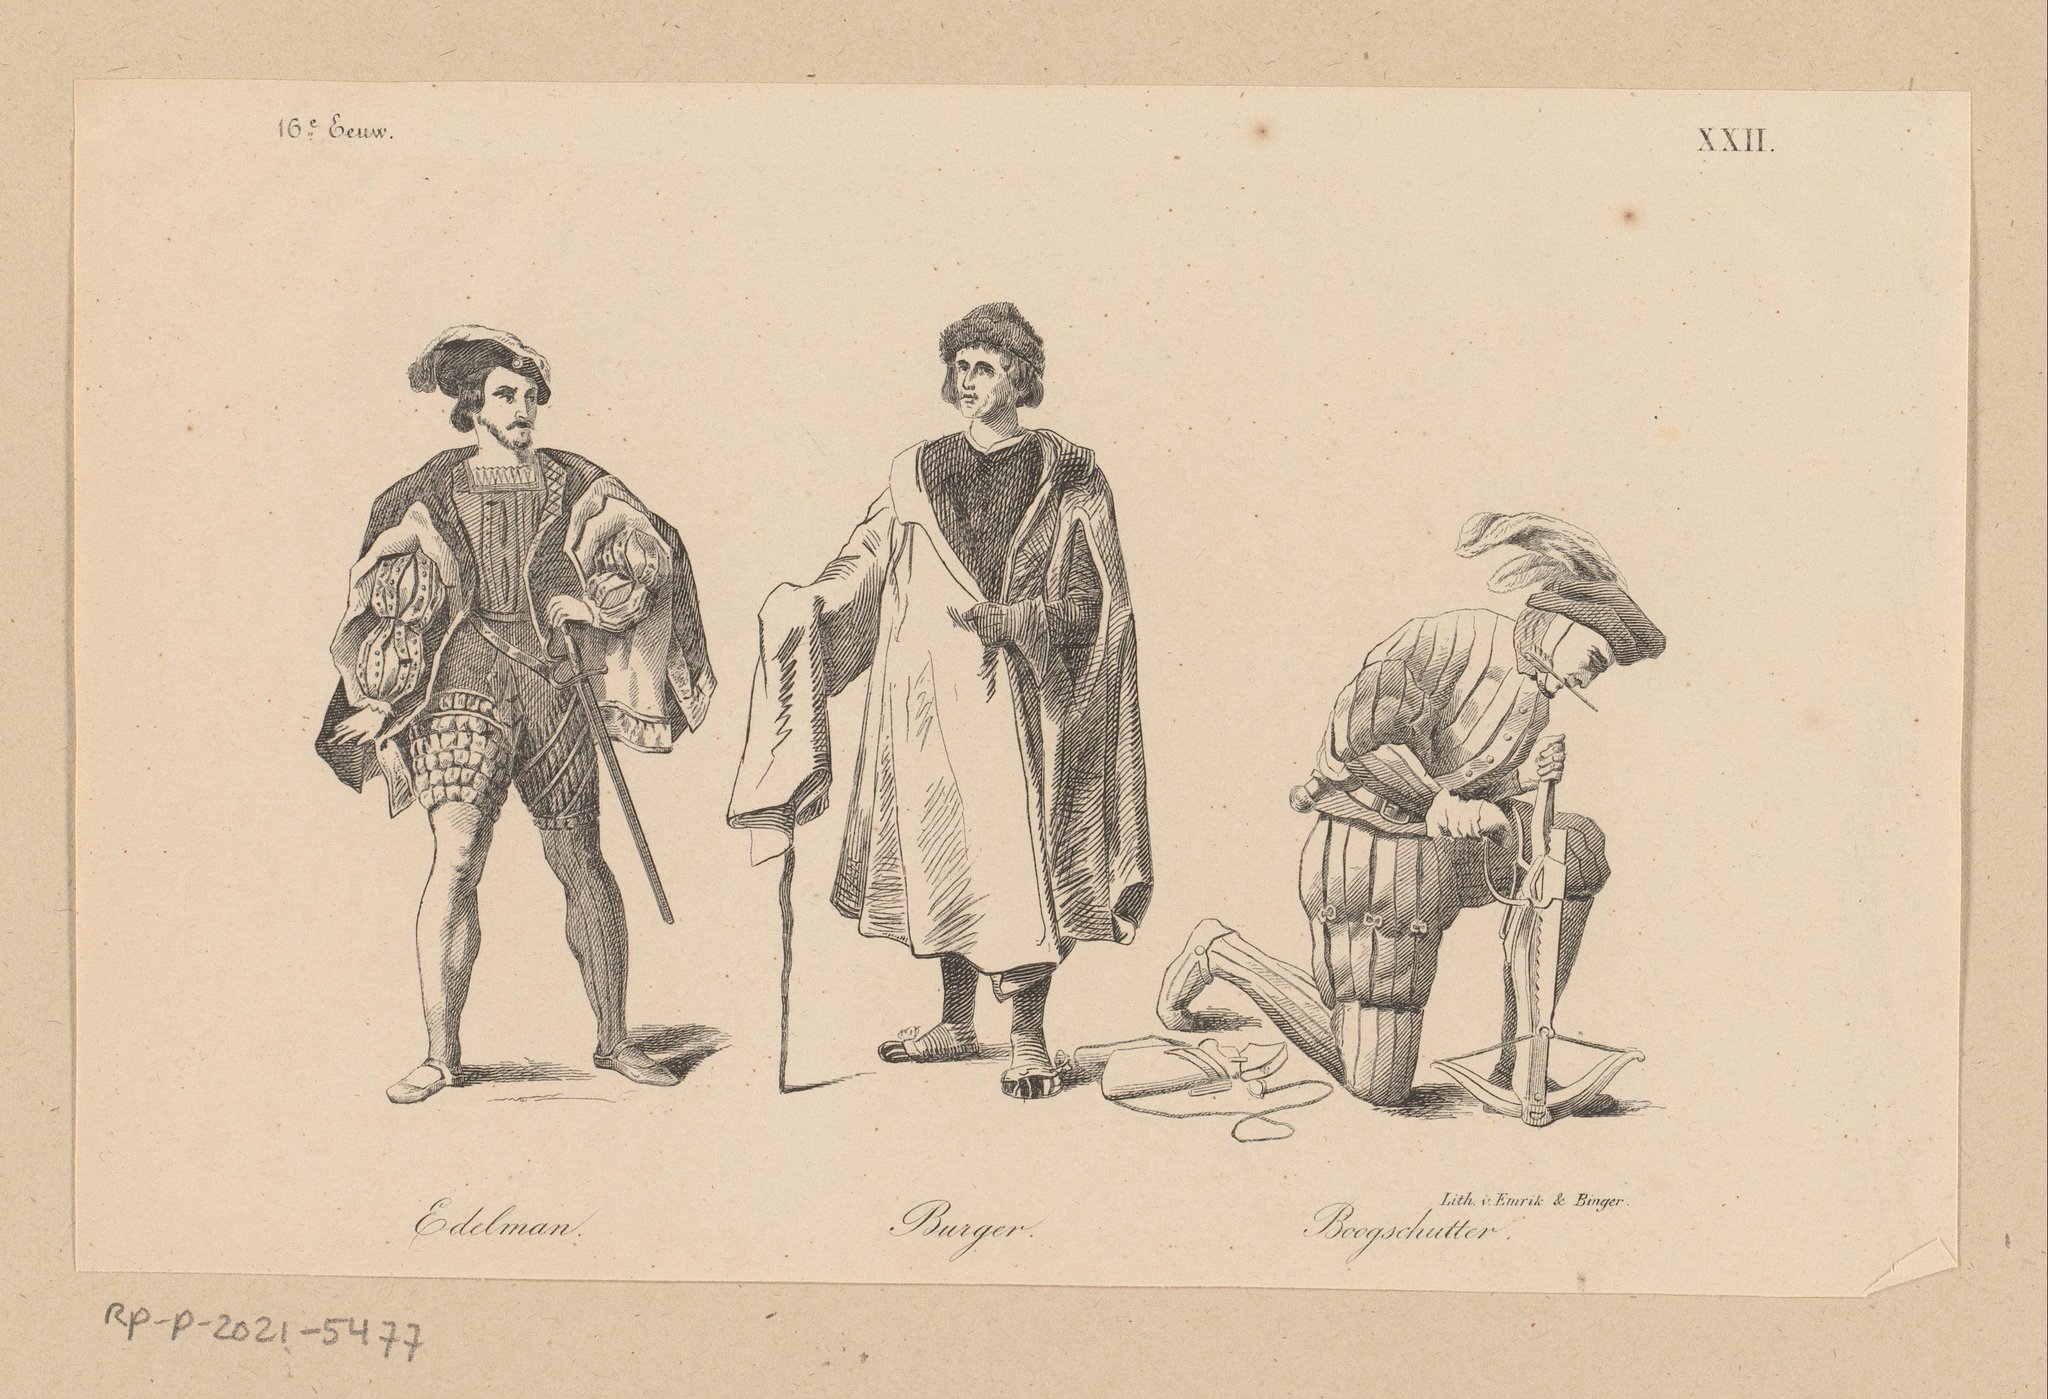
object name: print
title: Edelman / Burger / Boogschutter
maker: Anonymous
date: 1857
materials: paper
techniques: lithograph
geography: haarlem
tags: archer's weapons, clothes, costume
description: Prent uit: Hofdijk, Willem Jacob. Schets van de geschiedenis der Nederlanden. Amsterdam: Gebroeders Binger, 1857, p. 68/69.